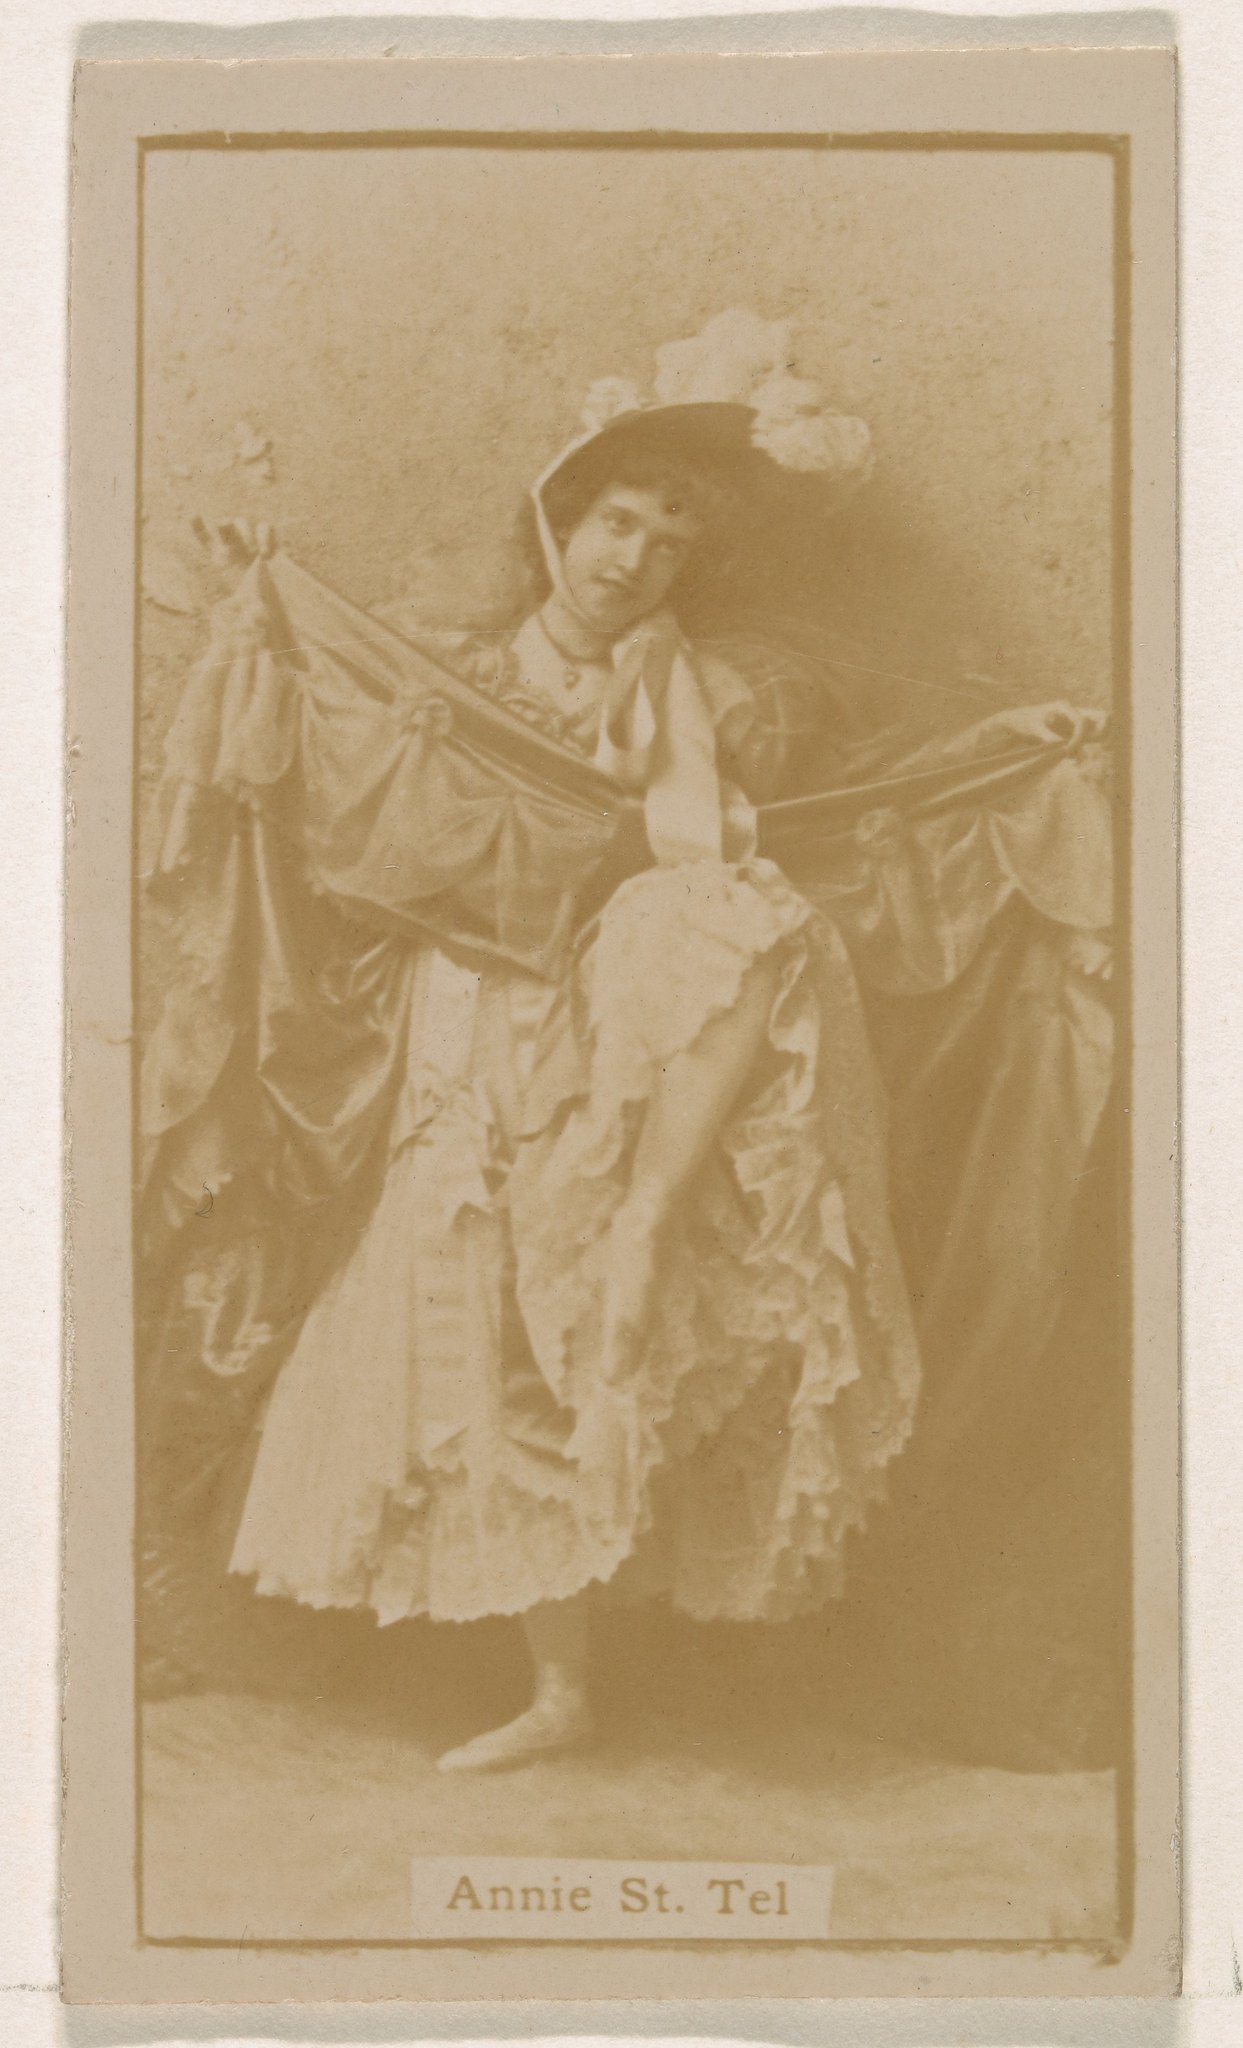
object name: photograph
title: Annie St. Tel, from the Actresses series (N245) issued by Kinney Brothers to promote Sweet Caporal Cigarettes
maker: kinney brothers tobacco company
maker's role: publisher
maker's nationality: american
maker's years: 1869-2011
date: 1890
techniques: albumen silver print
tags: portraits,women,actresses